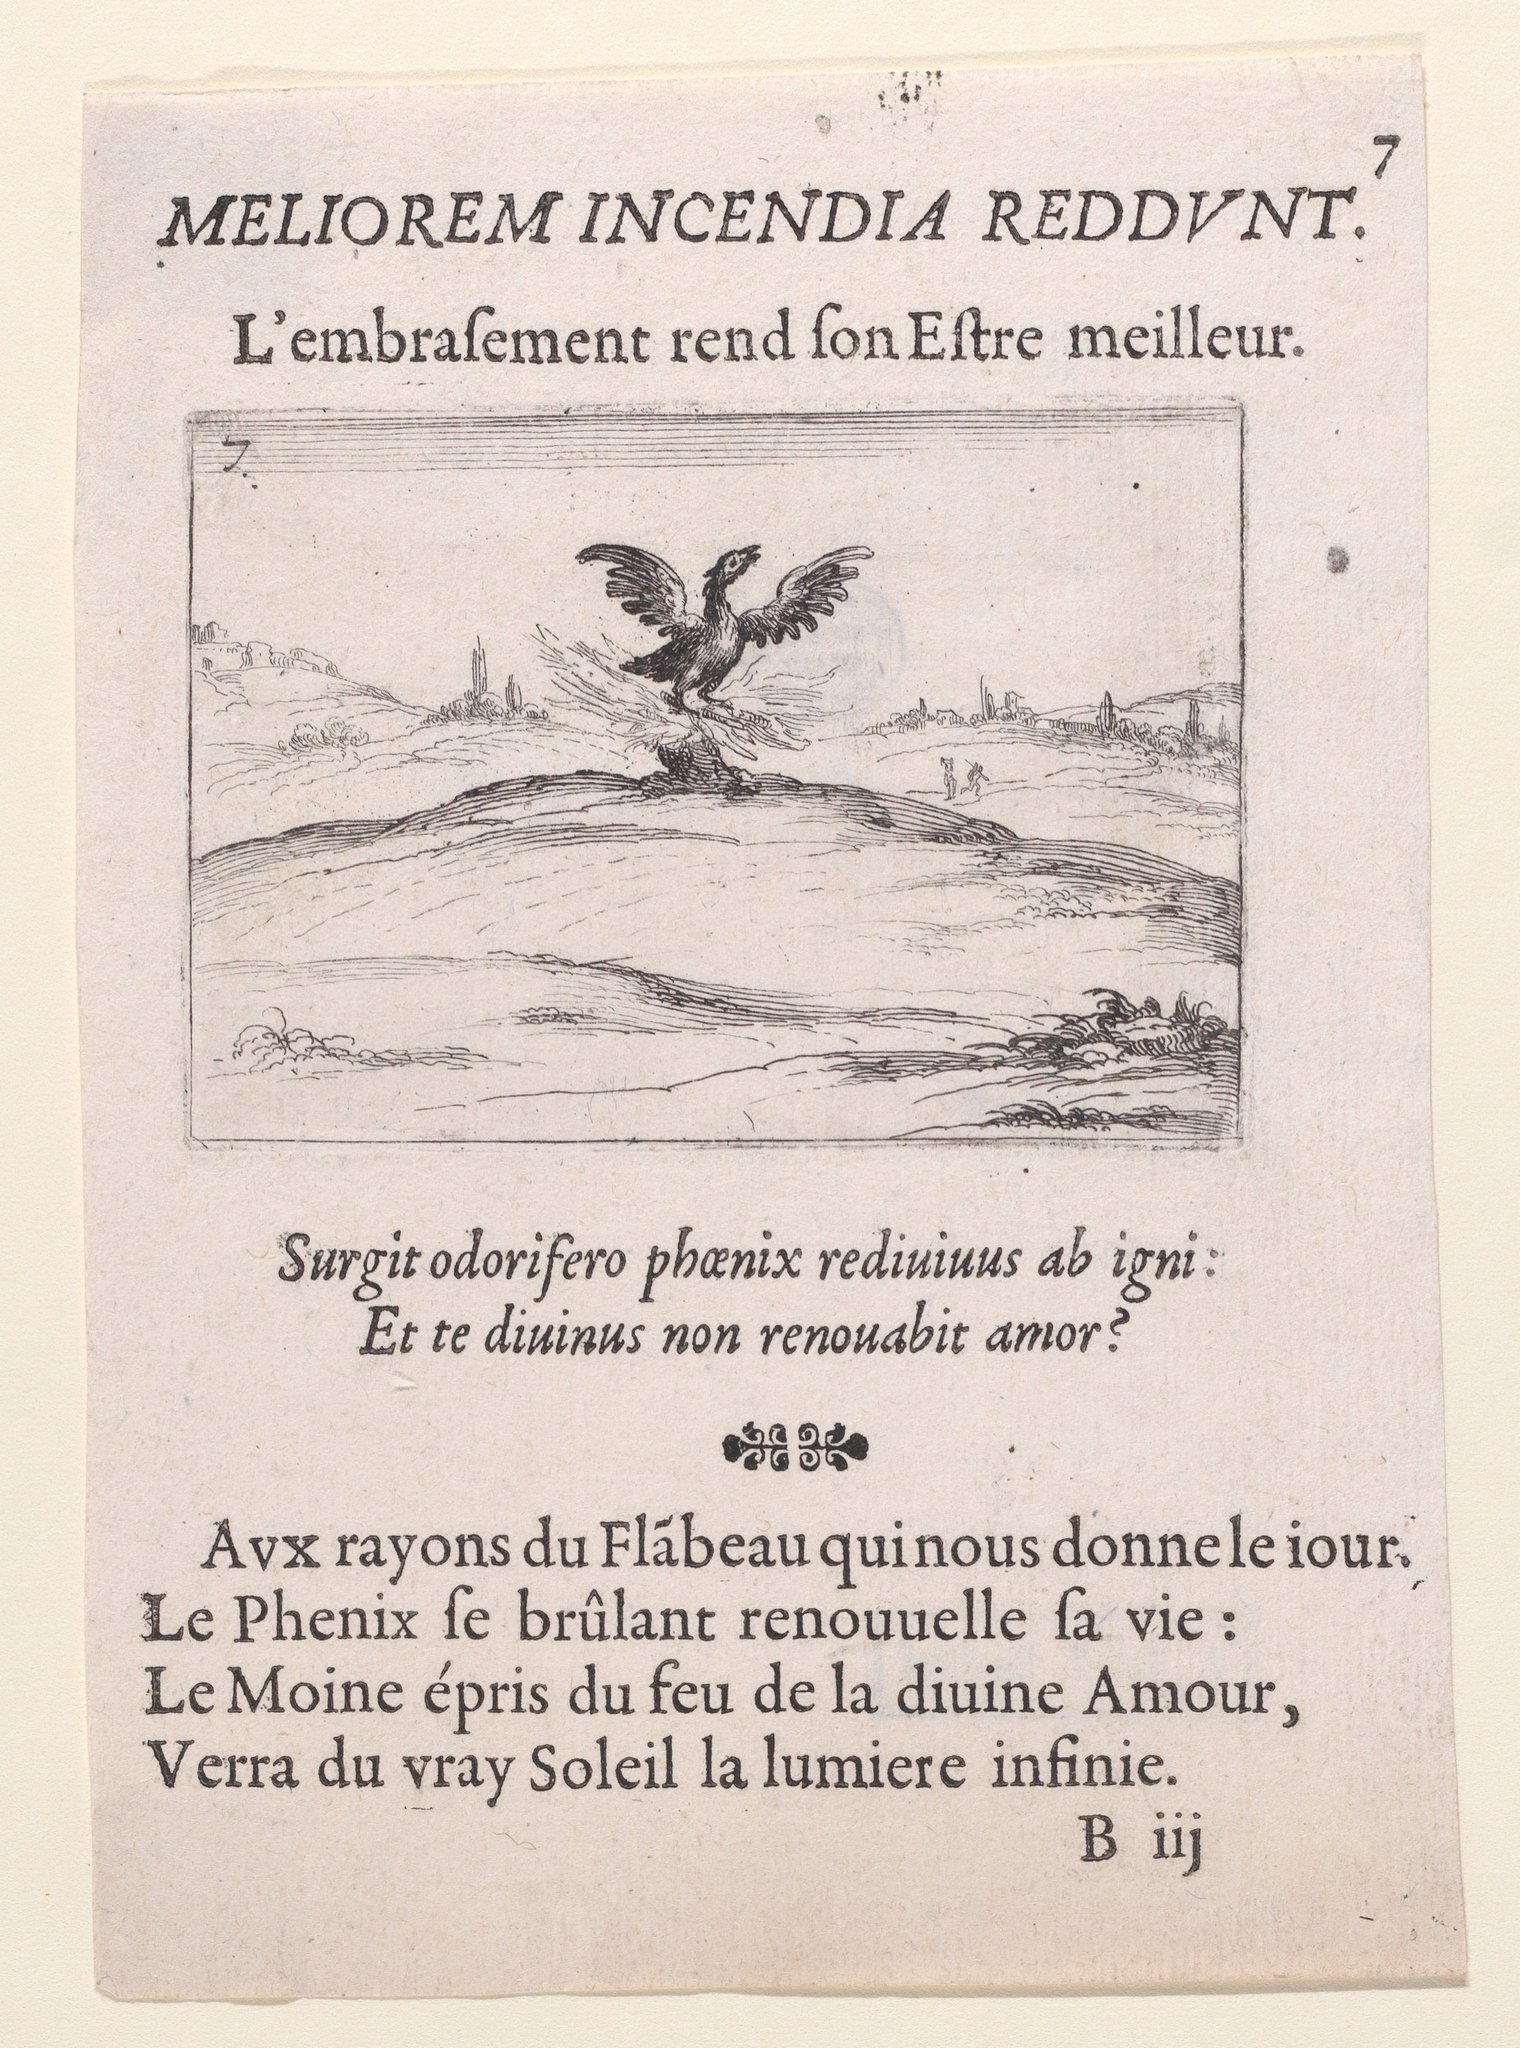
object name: print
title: Le Phénix se Brulant (The Phoenix is Burning), plate 7 from "Lux Claustri ou La Lumière du Cloitre" (The Light of the Cloisters)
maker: jacques callot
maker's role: artist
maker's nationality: french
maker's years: 1592-1635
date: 1621-1635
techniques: etching